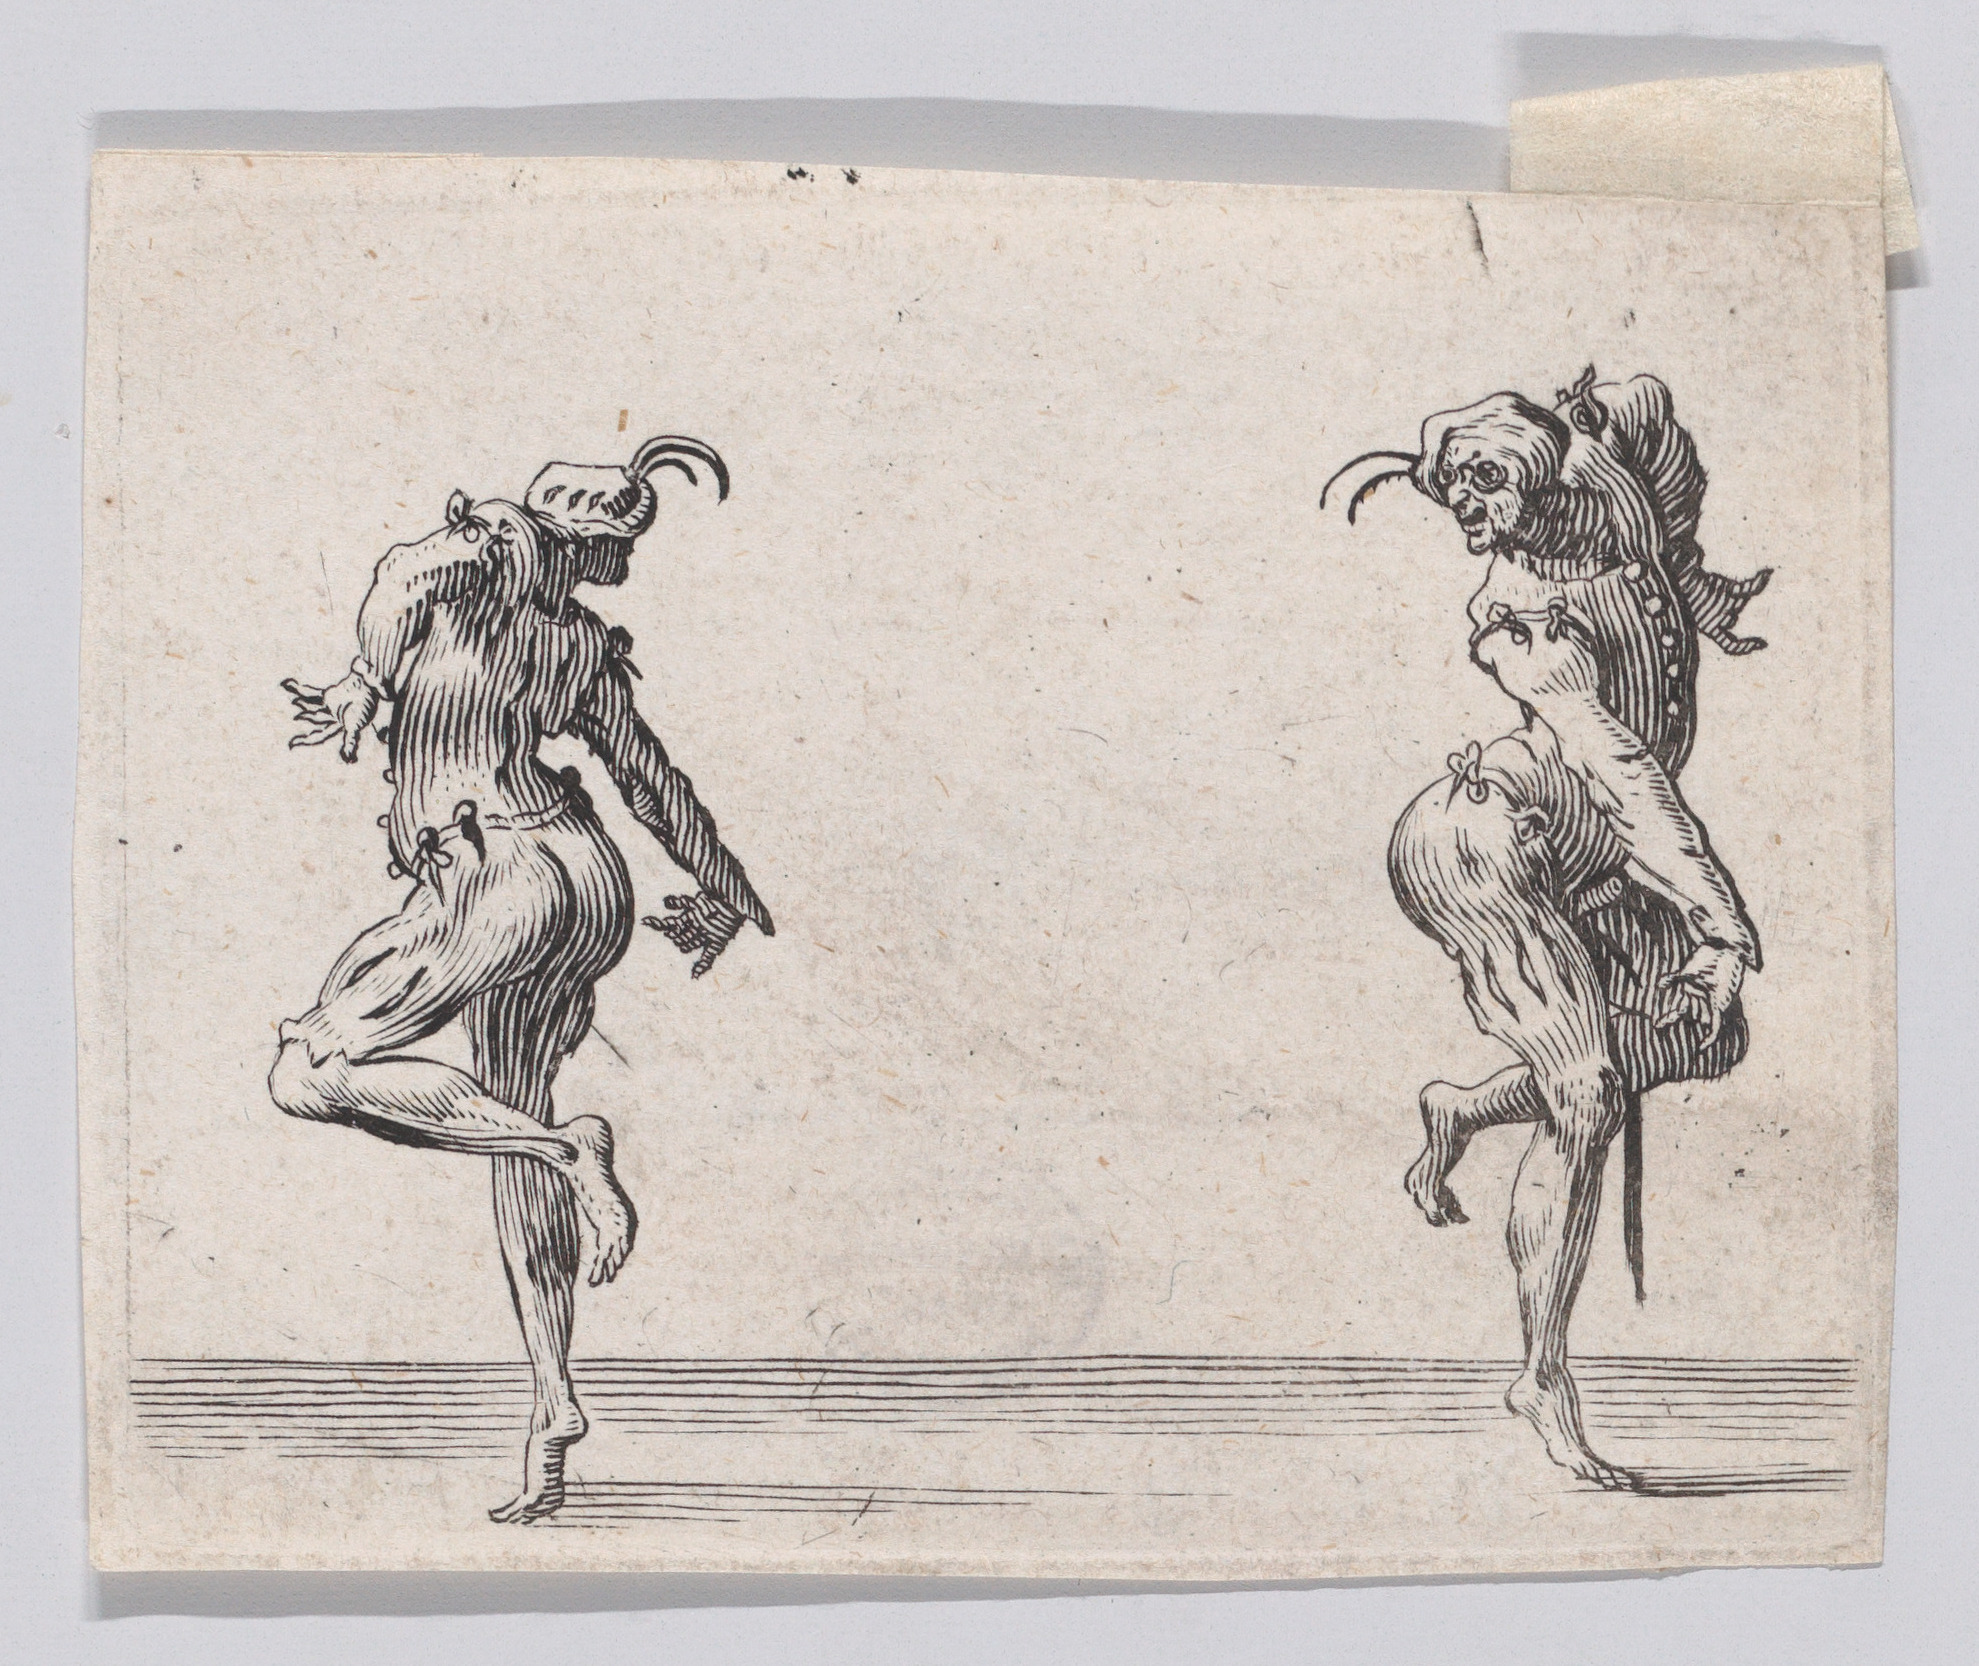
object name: print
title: Reverse Copy of Les Deux Pantalons se Tournant le Dos (Two Men in Pantsuits Turned Away from Each Other), from "Les Caprices"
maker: Anonymous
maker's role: artist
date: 1601-1700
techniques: etching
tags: men